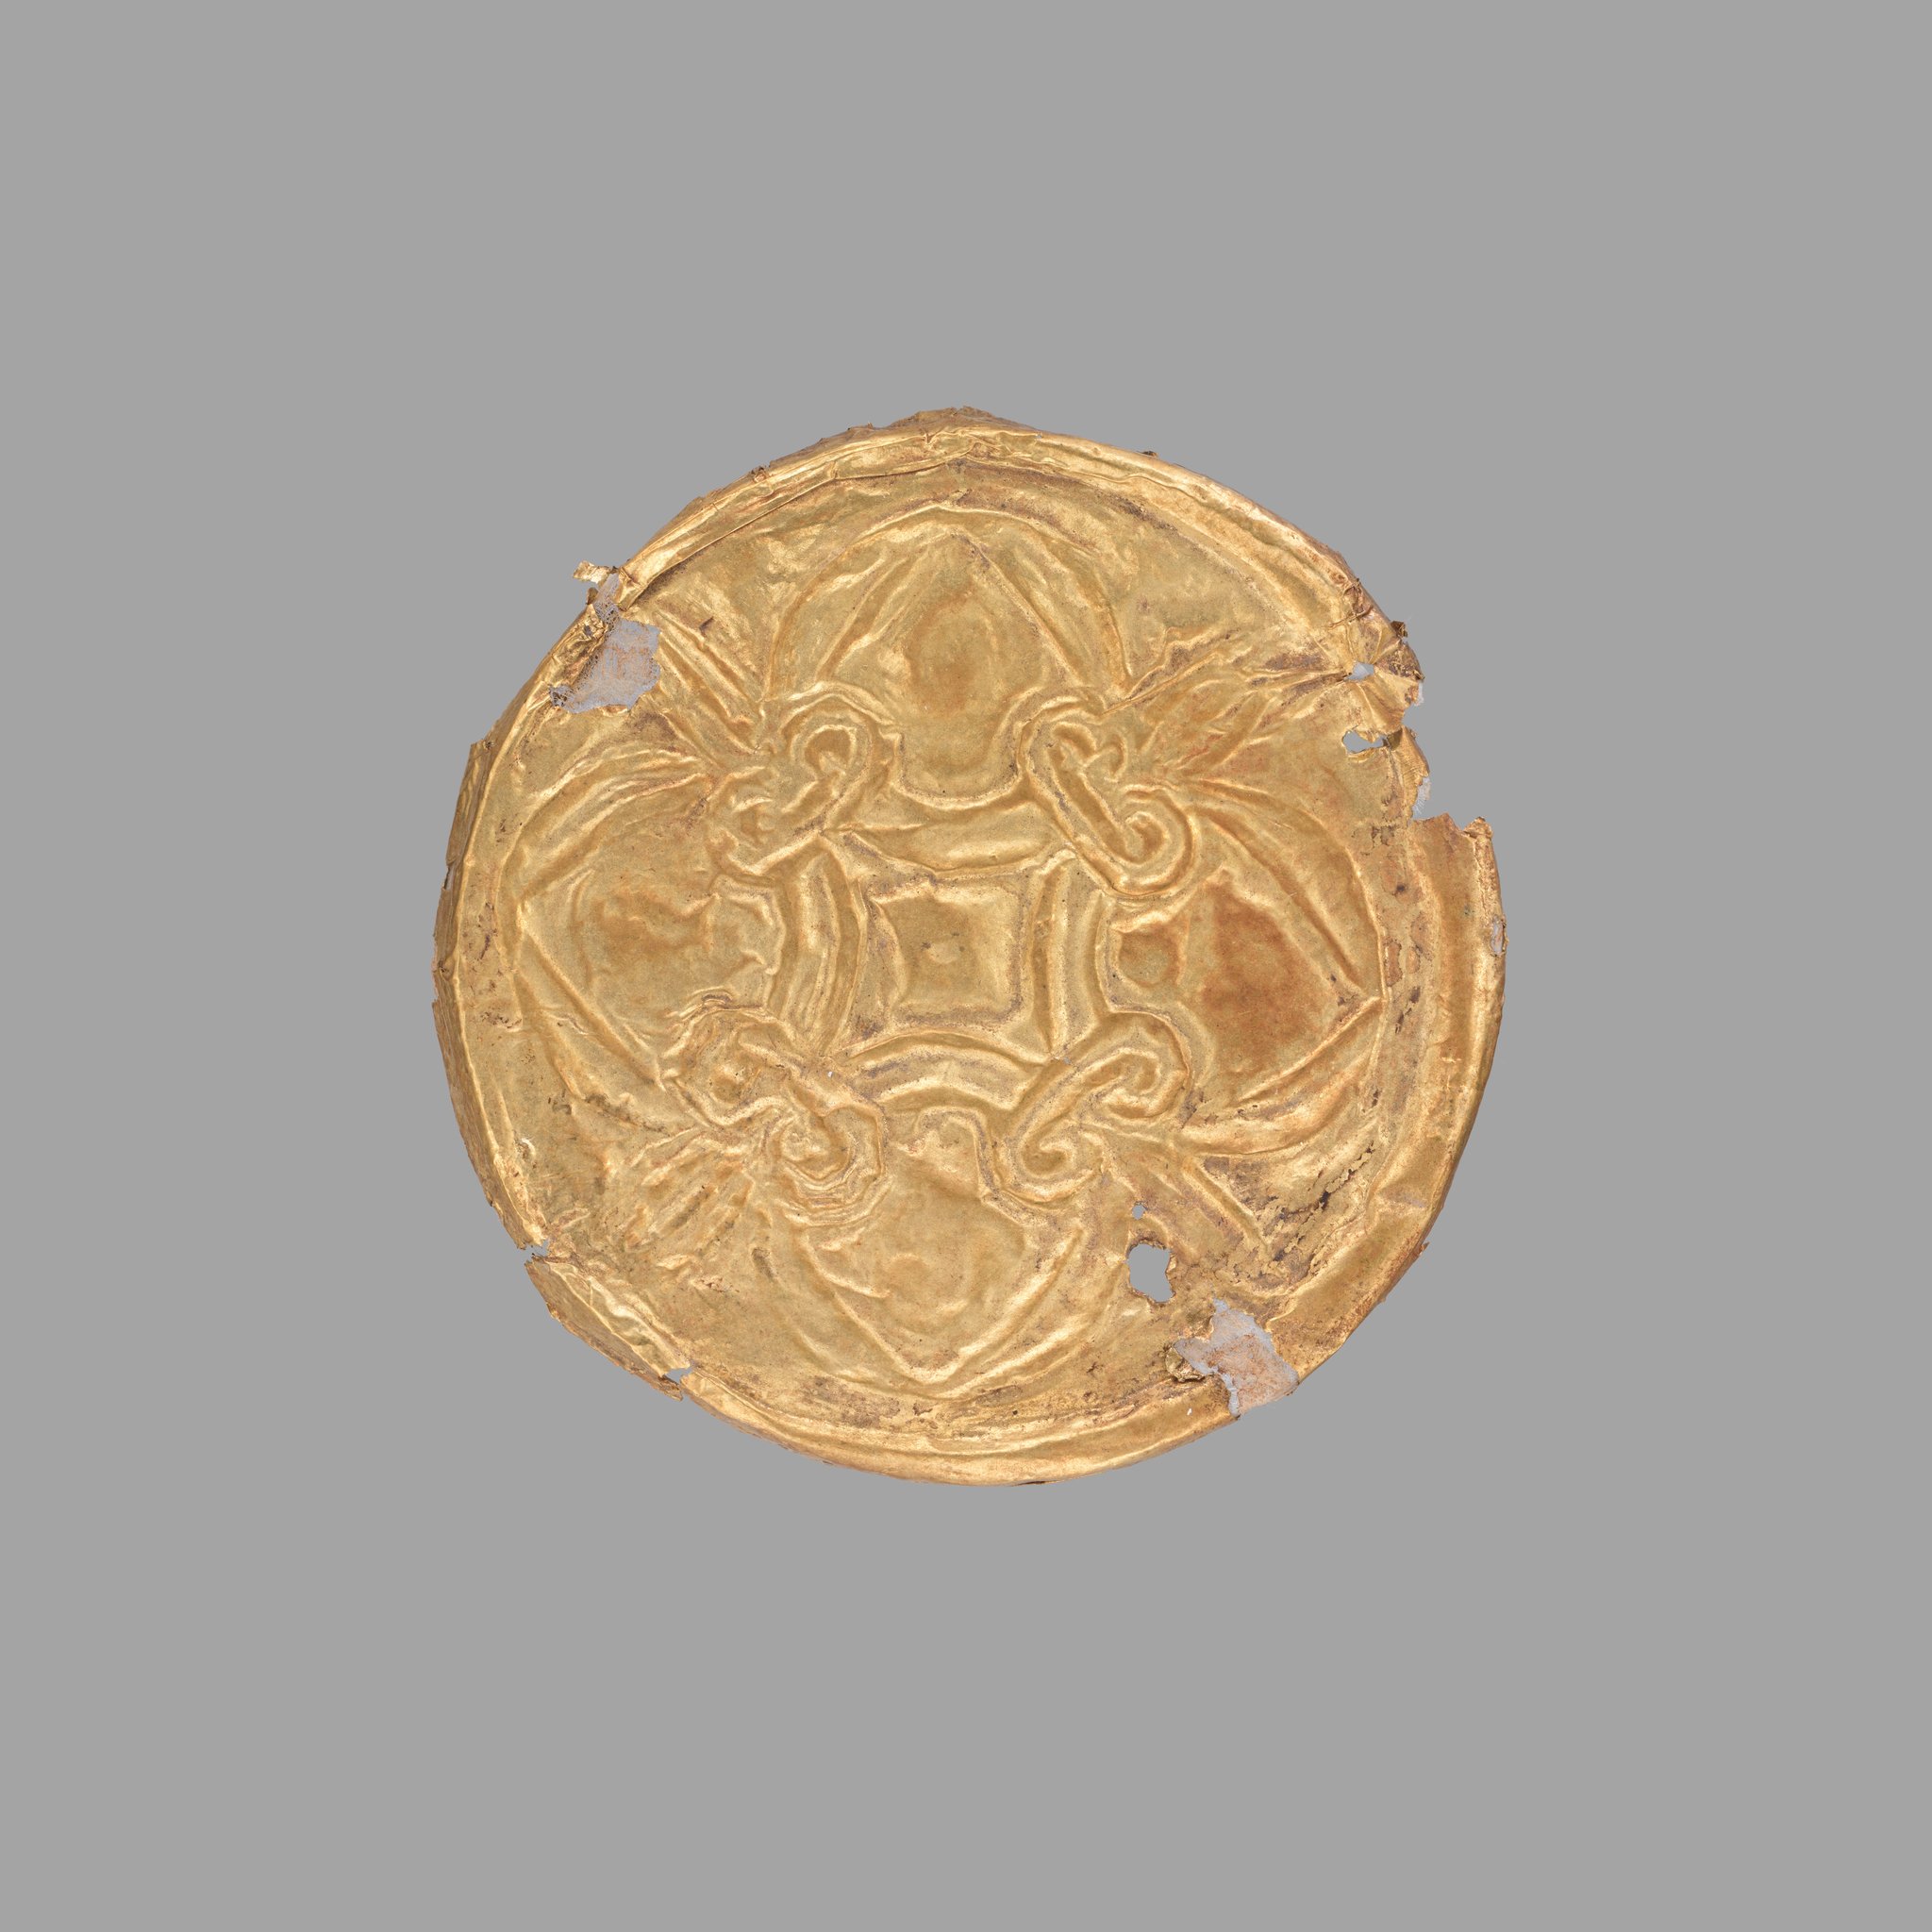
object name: roundel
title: Gold roundel with stamped designs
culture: cypriot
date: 1600-1050 BCE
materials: gold